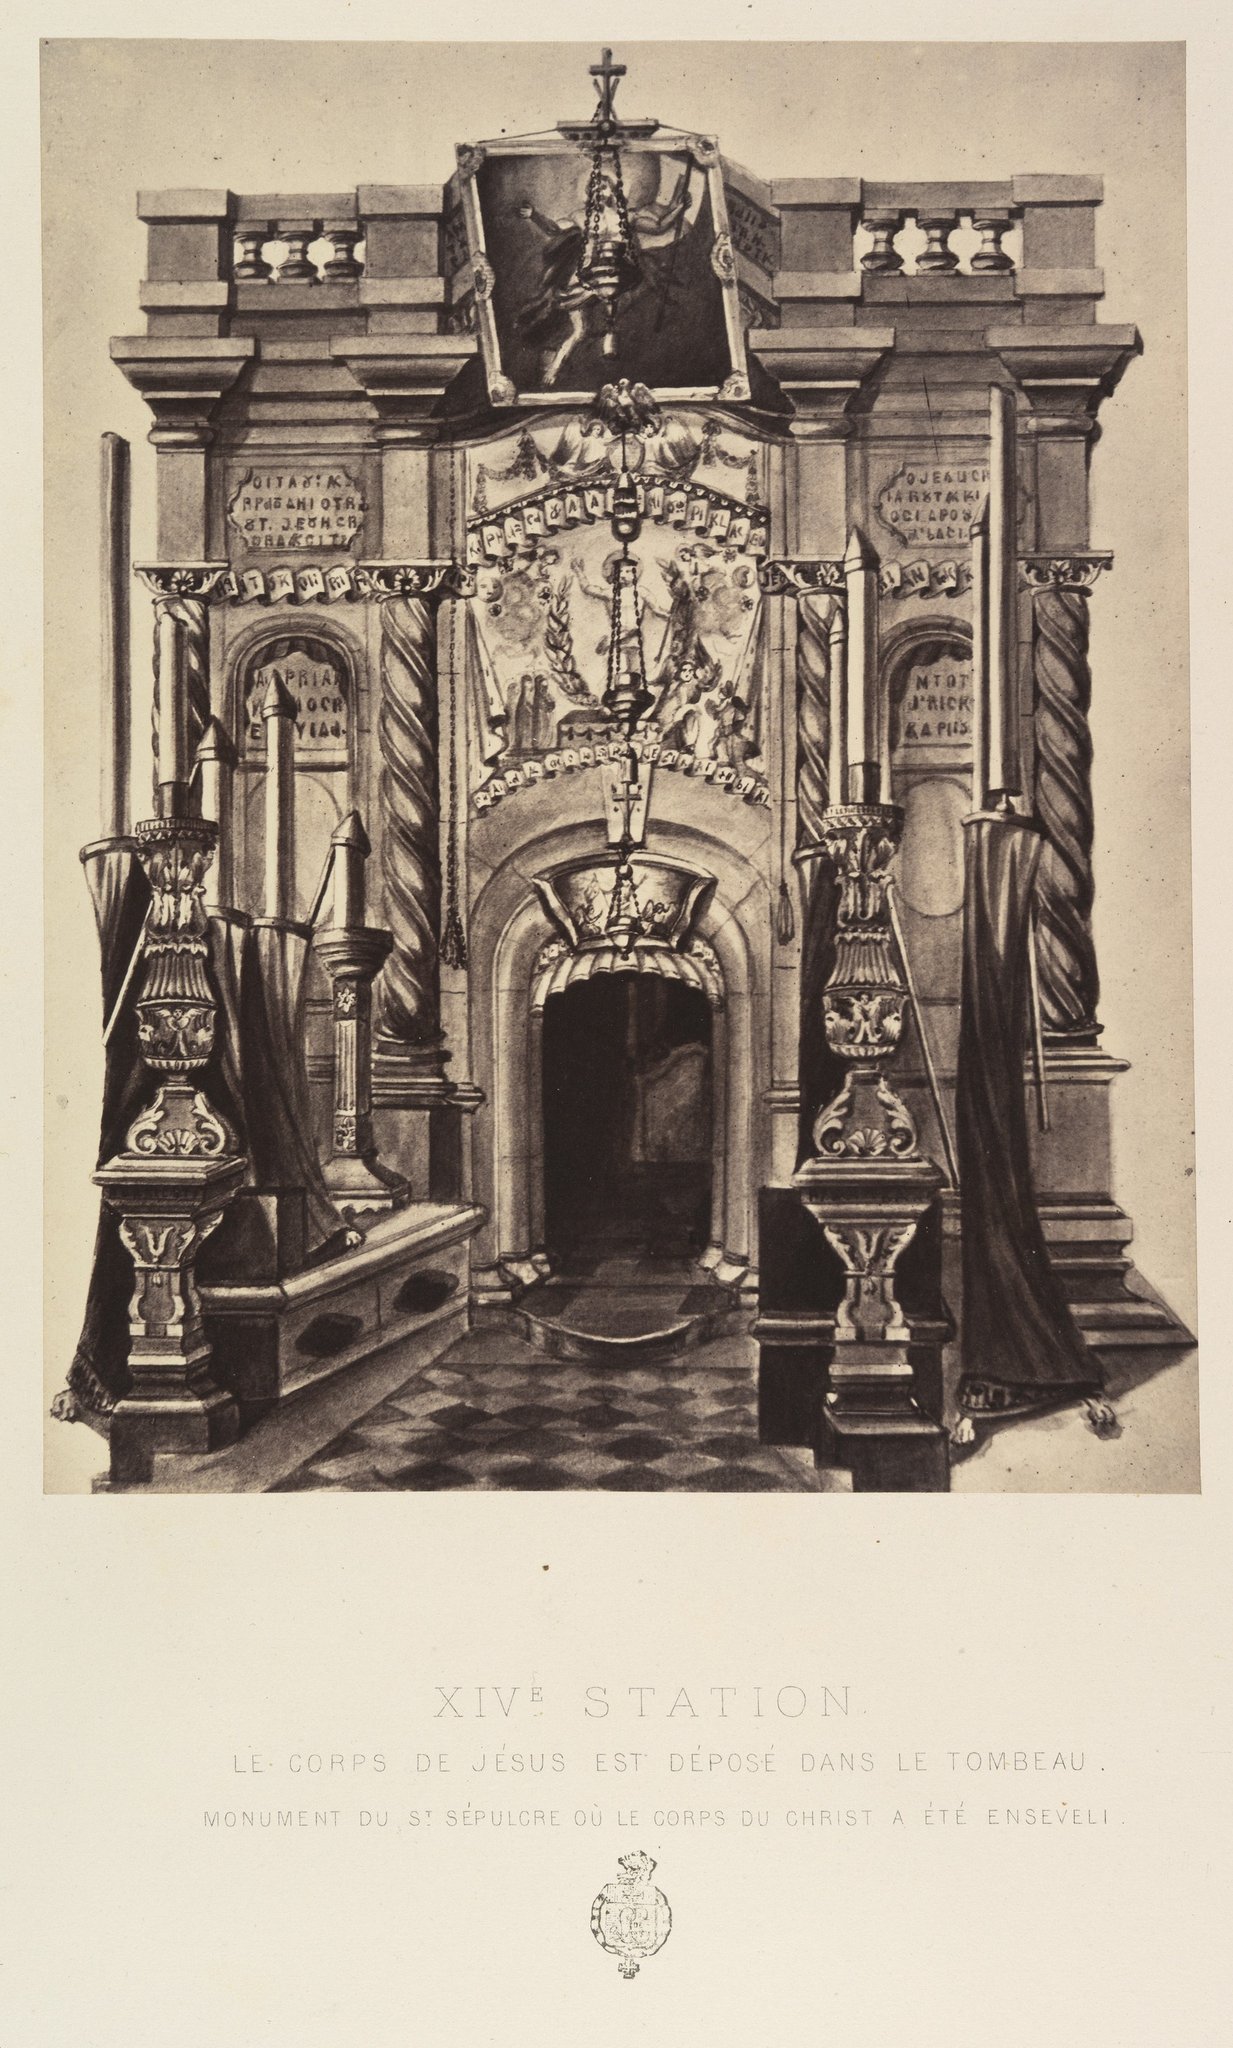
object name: photograph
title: XIVe Station. Le corps de Jésus est deposé dans le tombeau. Monument du St Sépulcre où le corps du Christ a été enseveli.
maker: louis de clercq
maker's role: artist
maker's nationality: french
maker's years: 1837-1901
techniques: albumen silver print, paper negative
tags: architecture,monuments